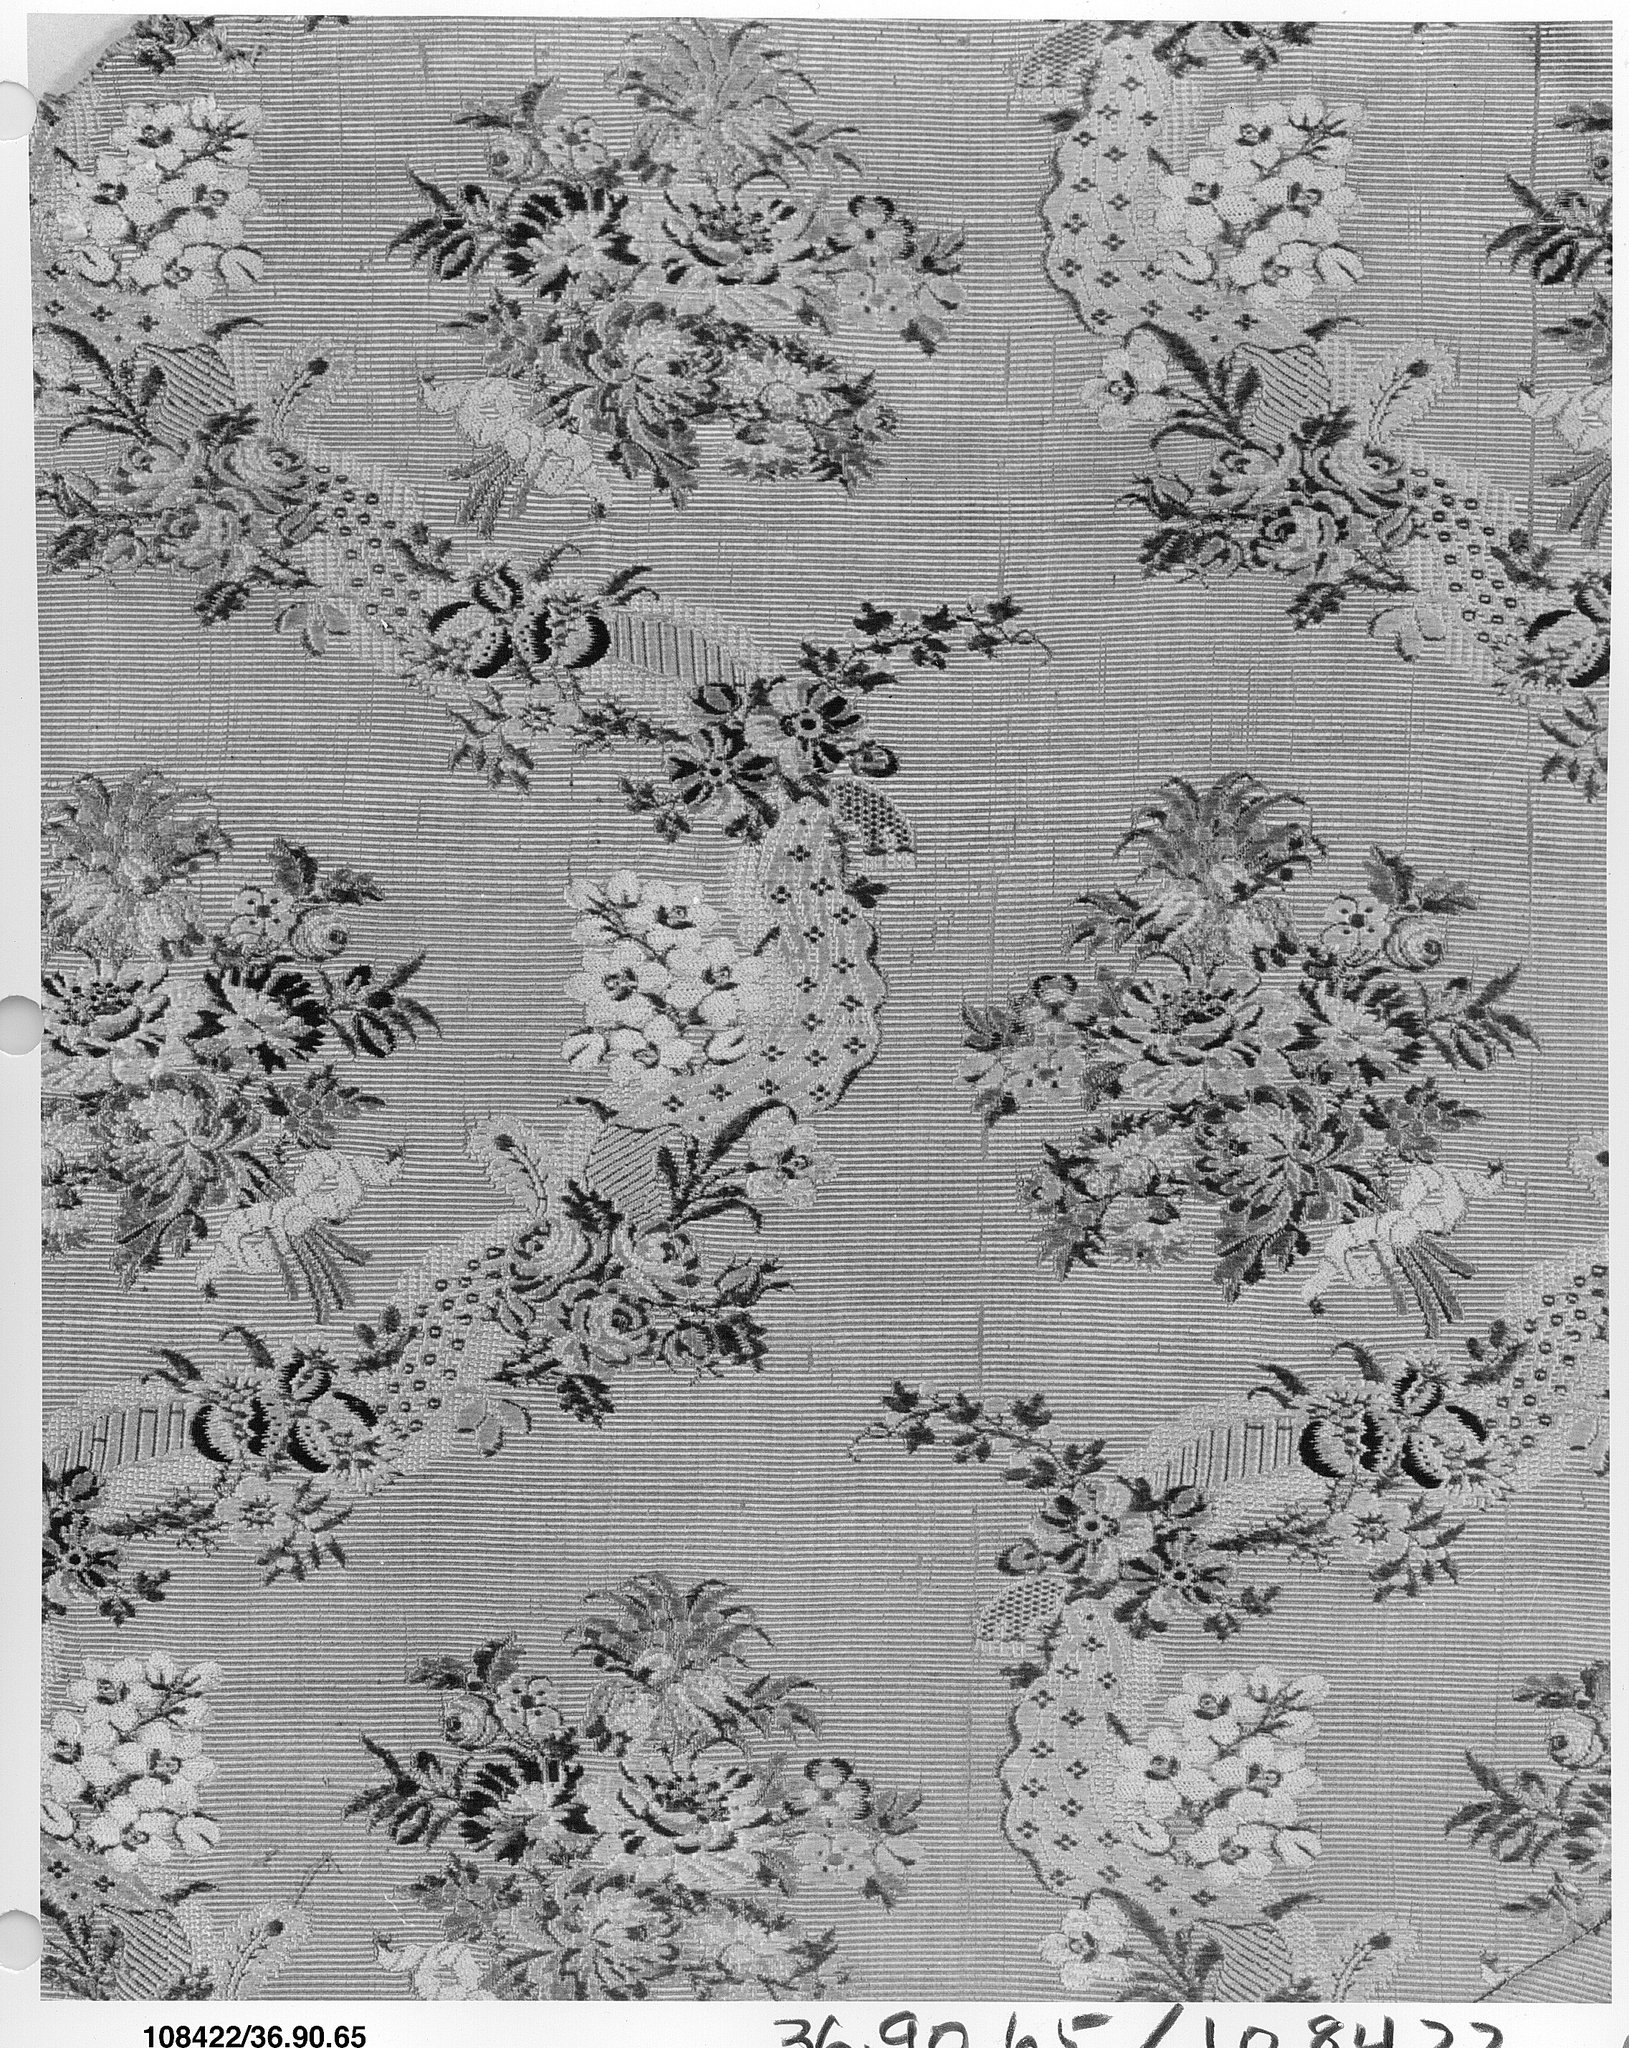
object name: piece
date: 1734-1766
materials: silk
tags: flowers